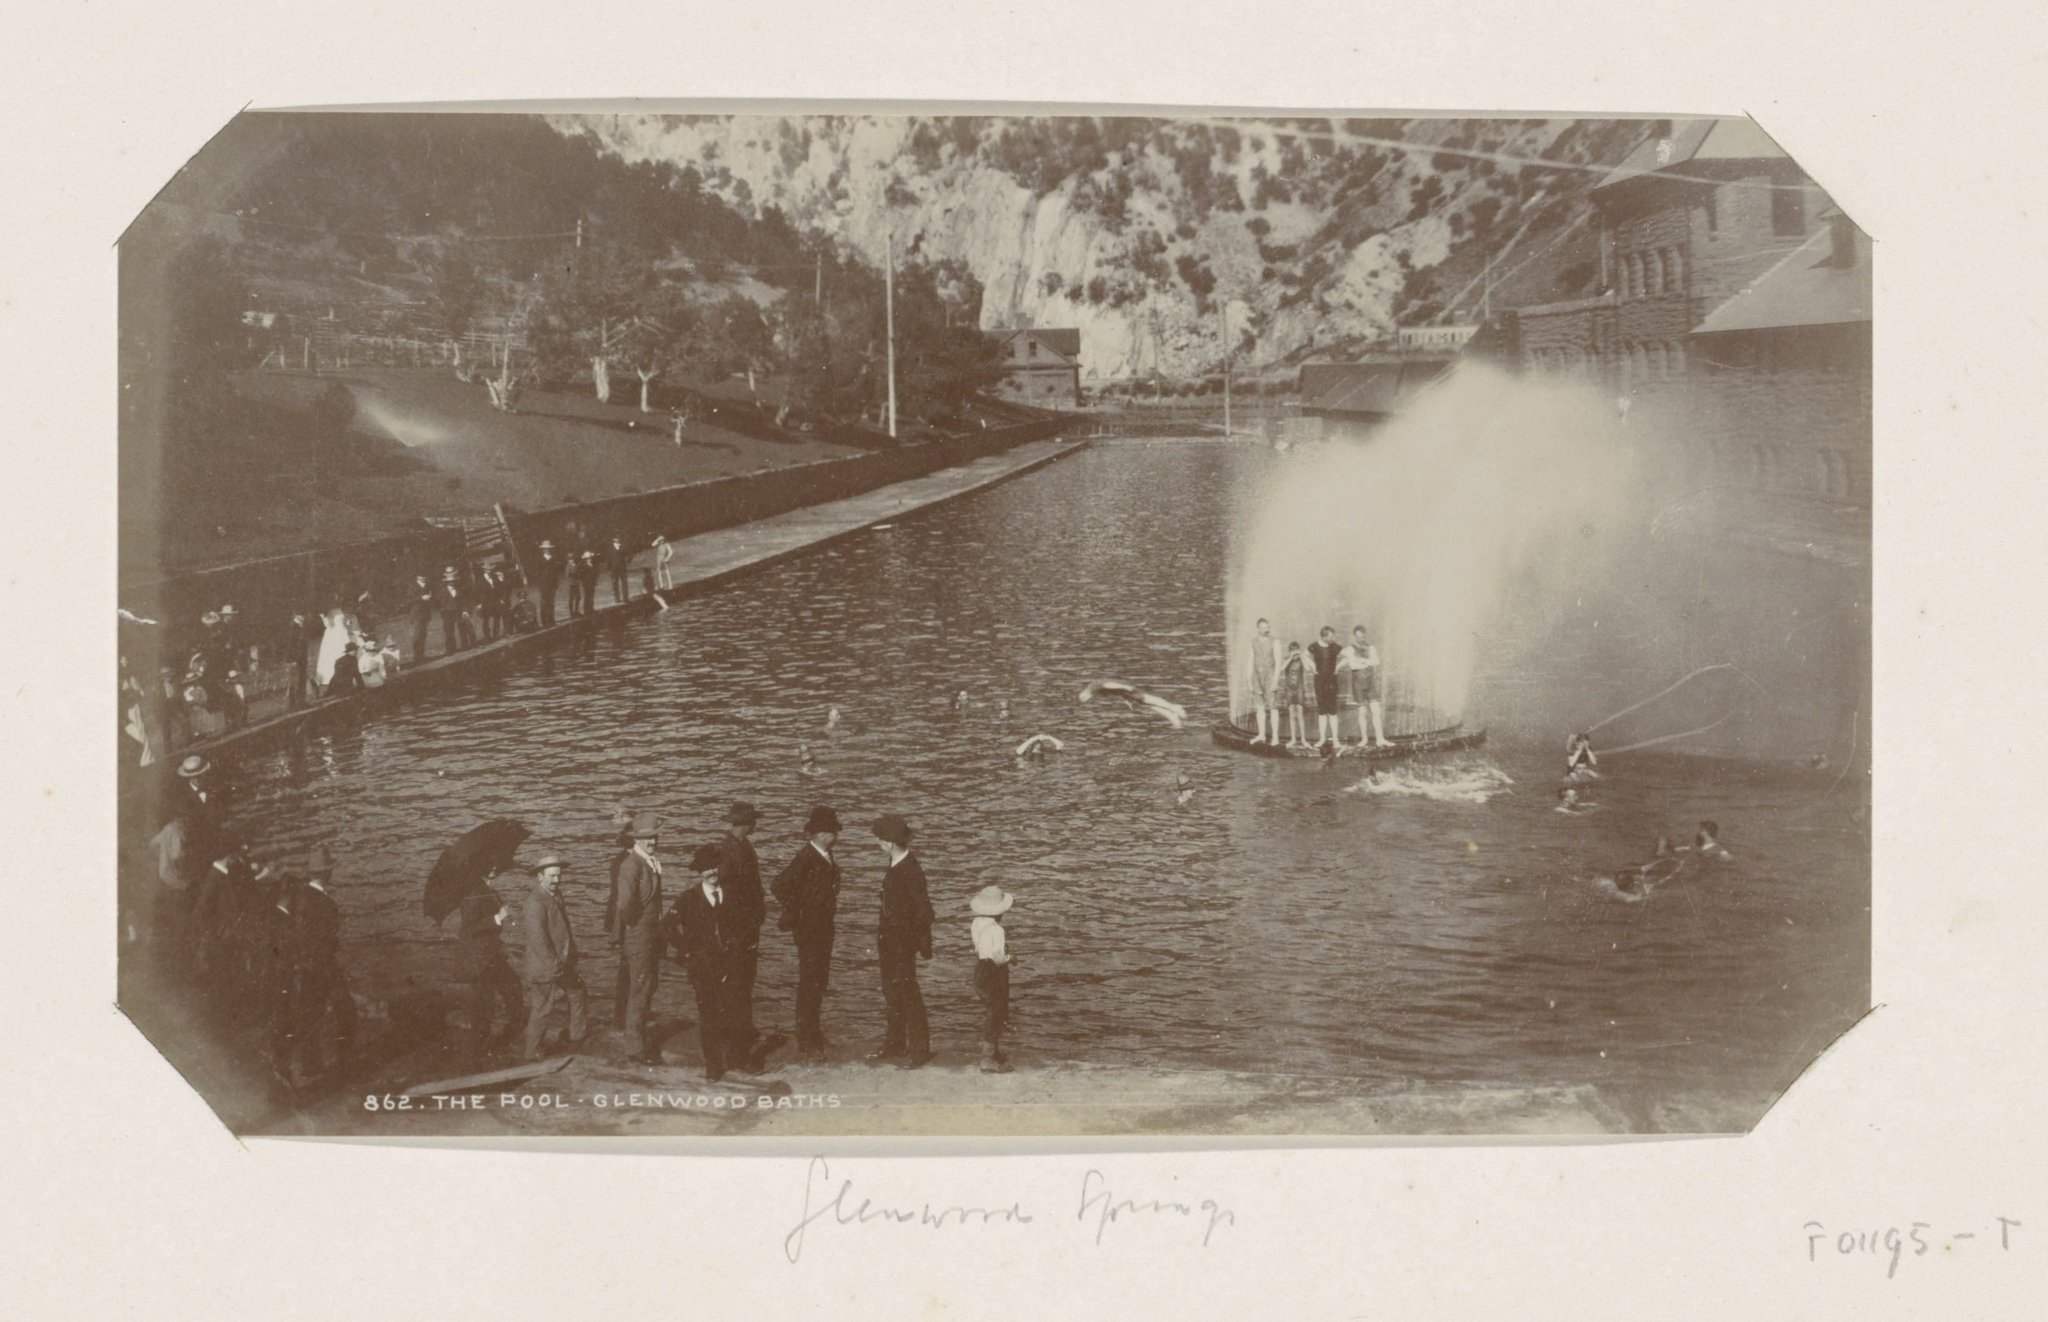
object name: photograph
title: The Pool - Glenwood Baths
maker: william henry jackson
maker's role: fotograaf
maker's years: 1843-1942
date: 1860-1900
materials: cardboard, paper, photographic support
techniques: gelatin silver print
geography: glenwood springs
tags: pond, pool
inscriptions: negative number: ‘862’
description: Onderdeel van Fotoalbum van een reis door de Verenigde Staten, Honolulu, Nederlands-Indië, Aden, Zanzibar en Zuidelijk Afrika.